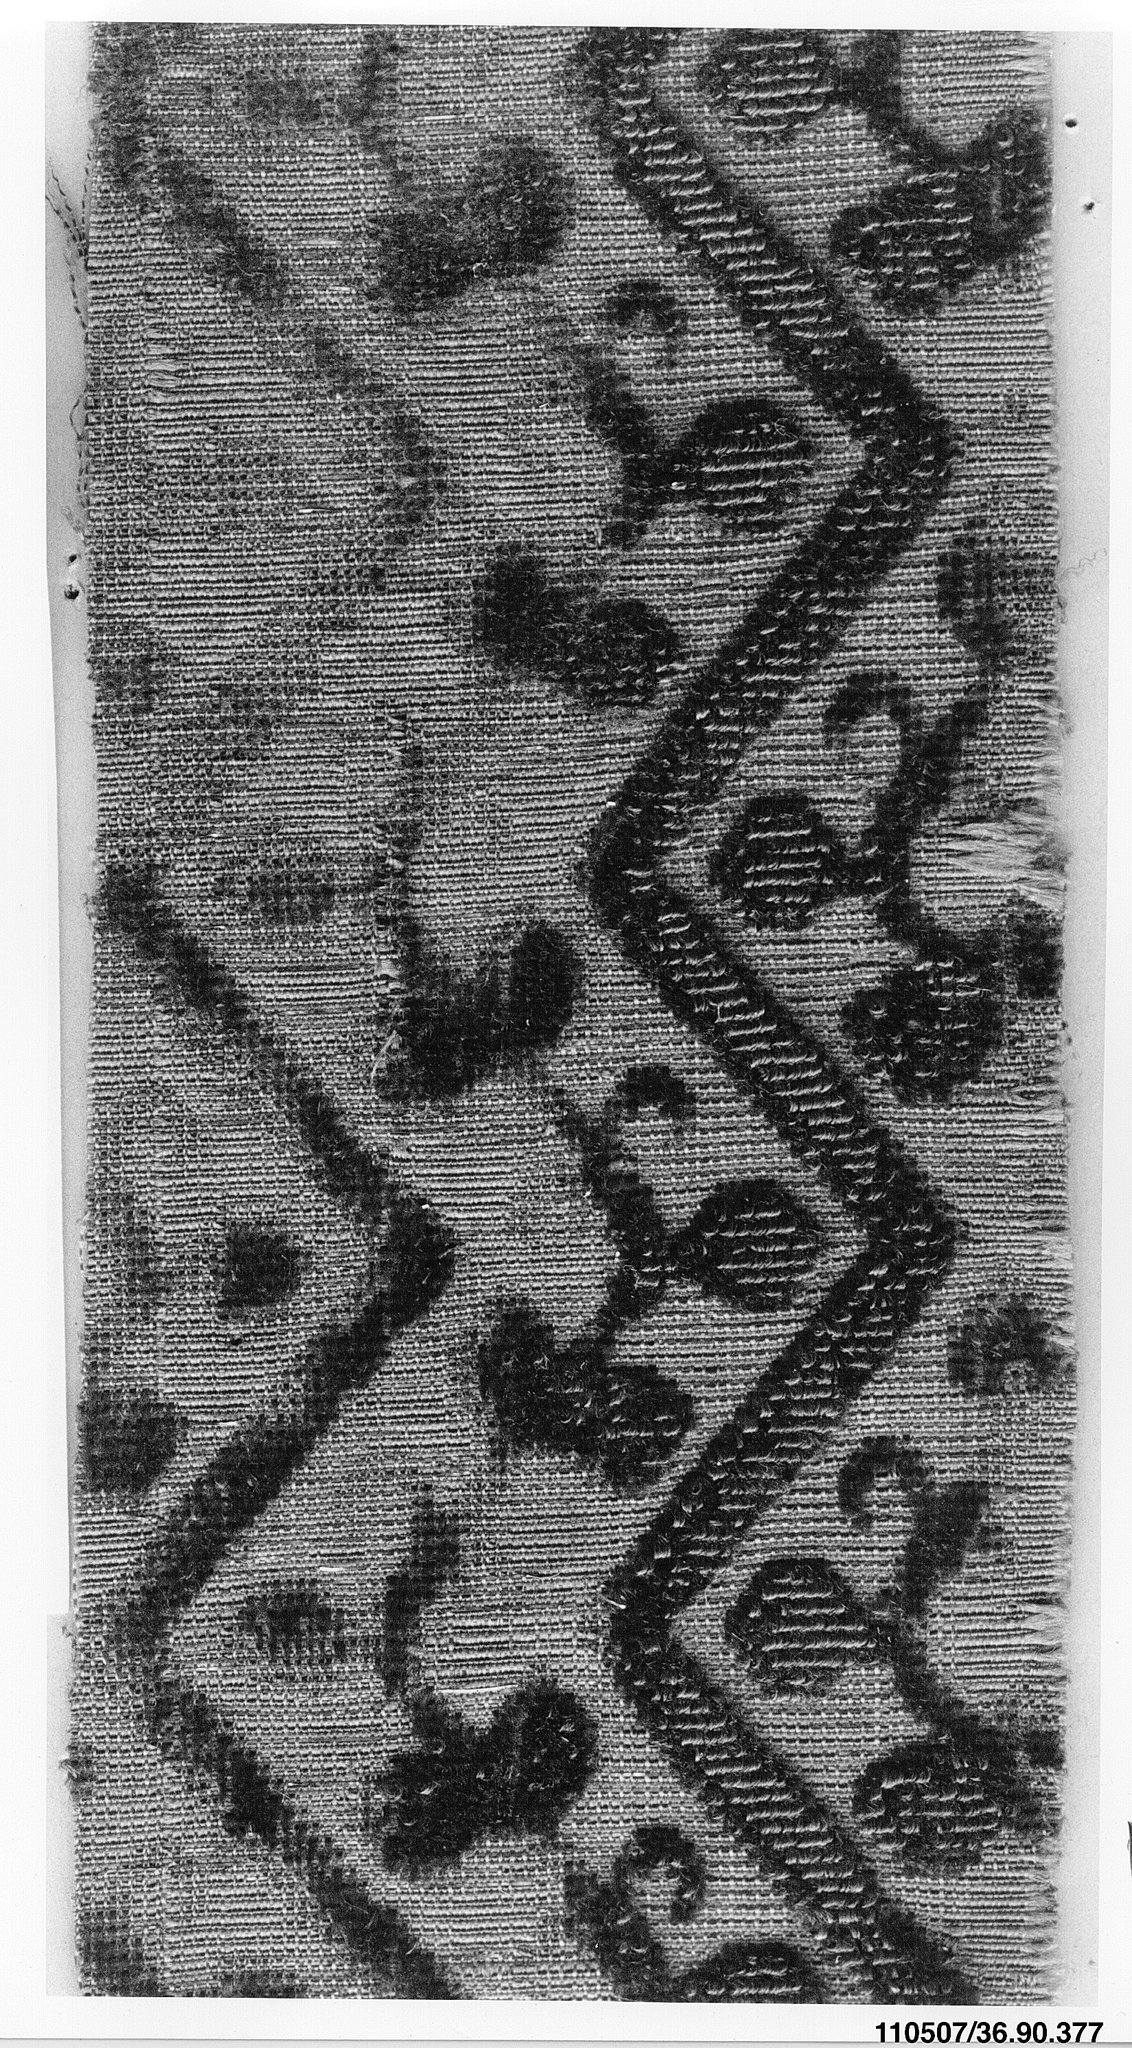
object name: piece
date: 1501-1700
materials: metal thread, silk